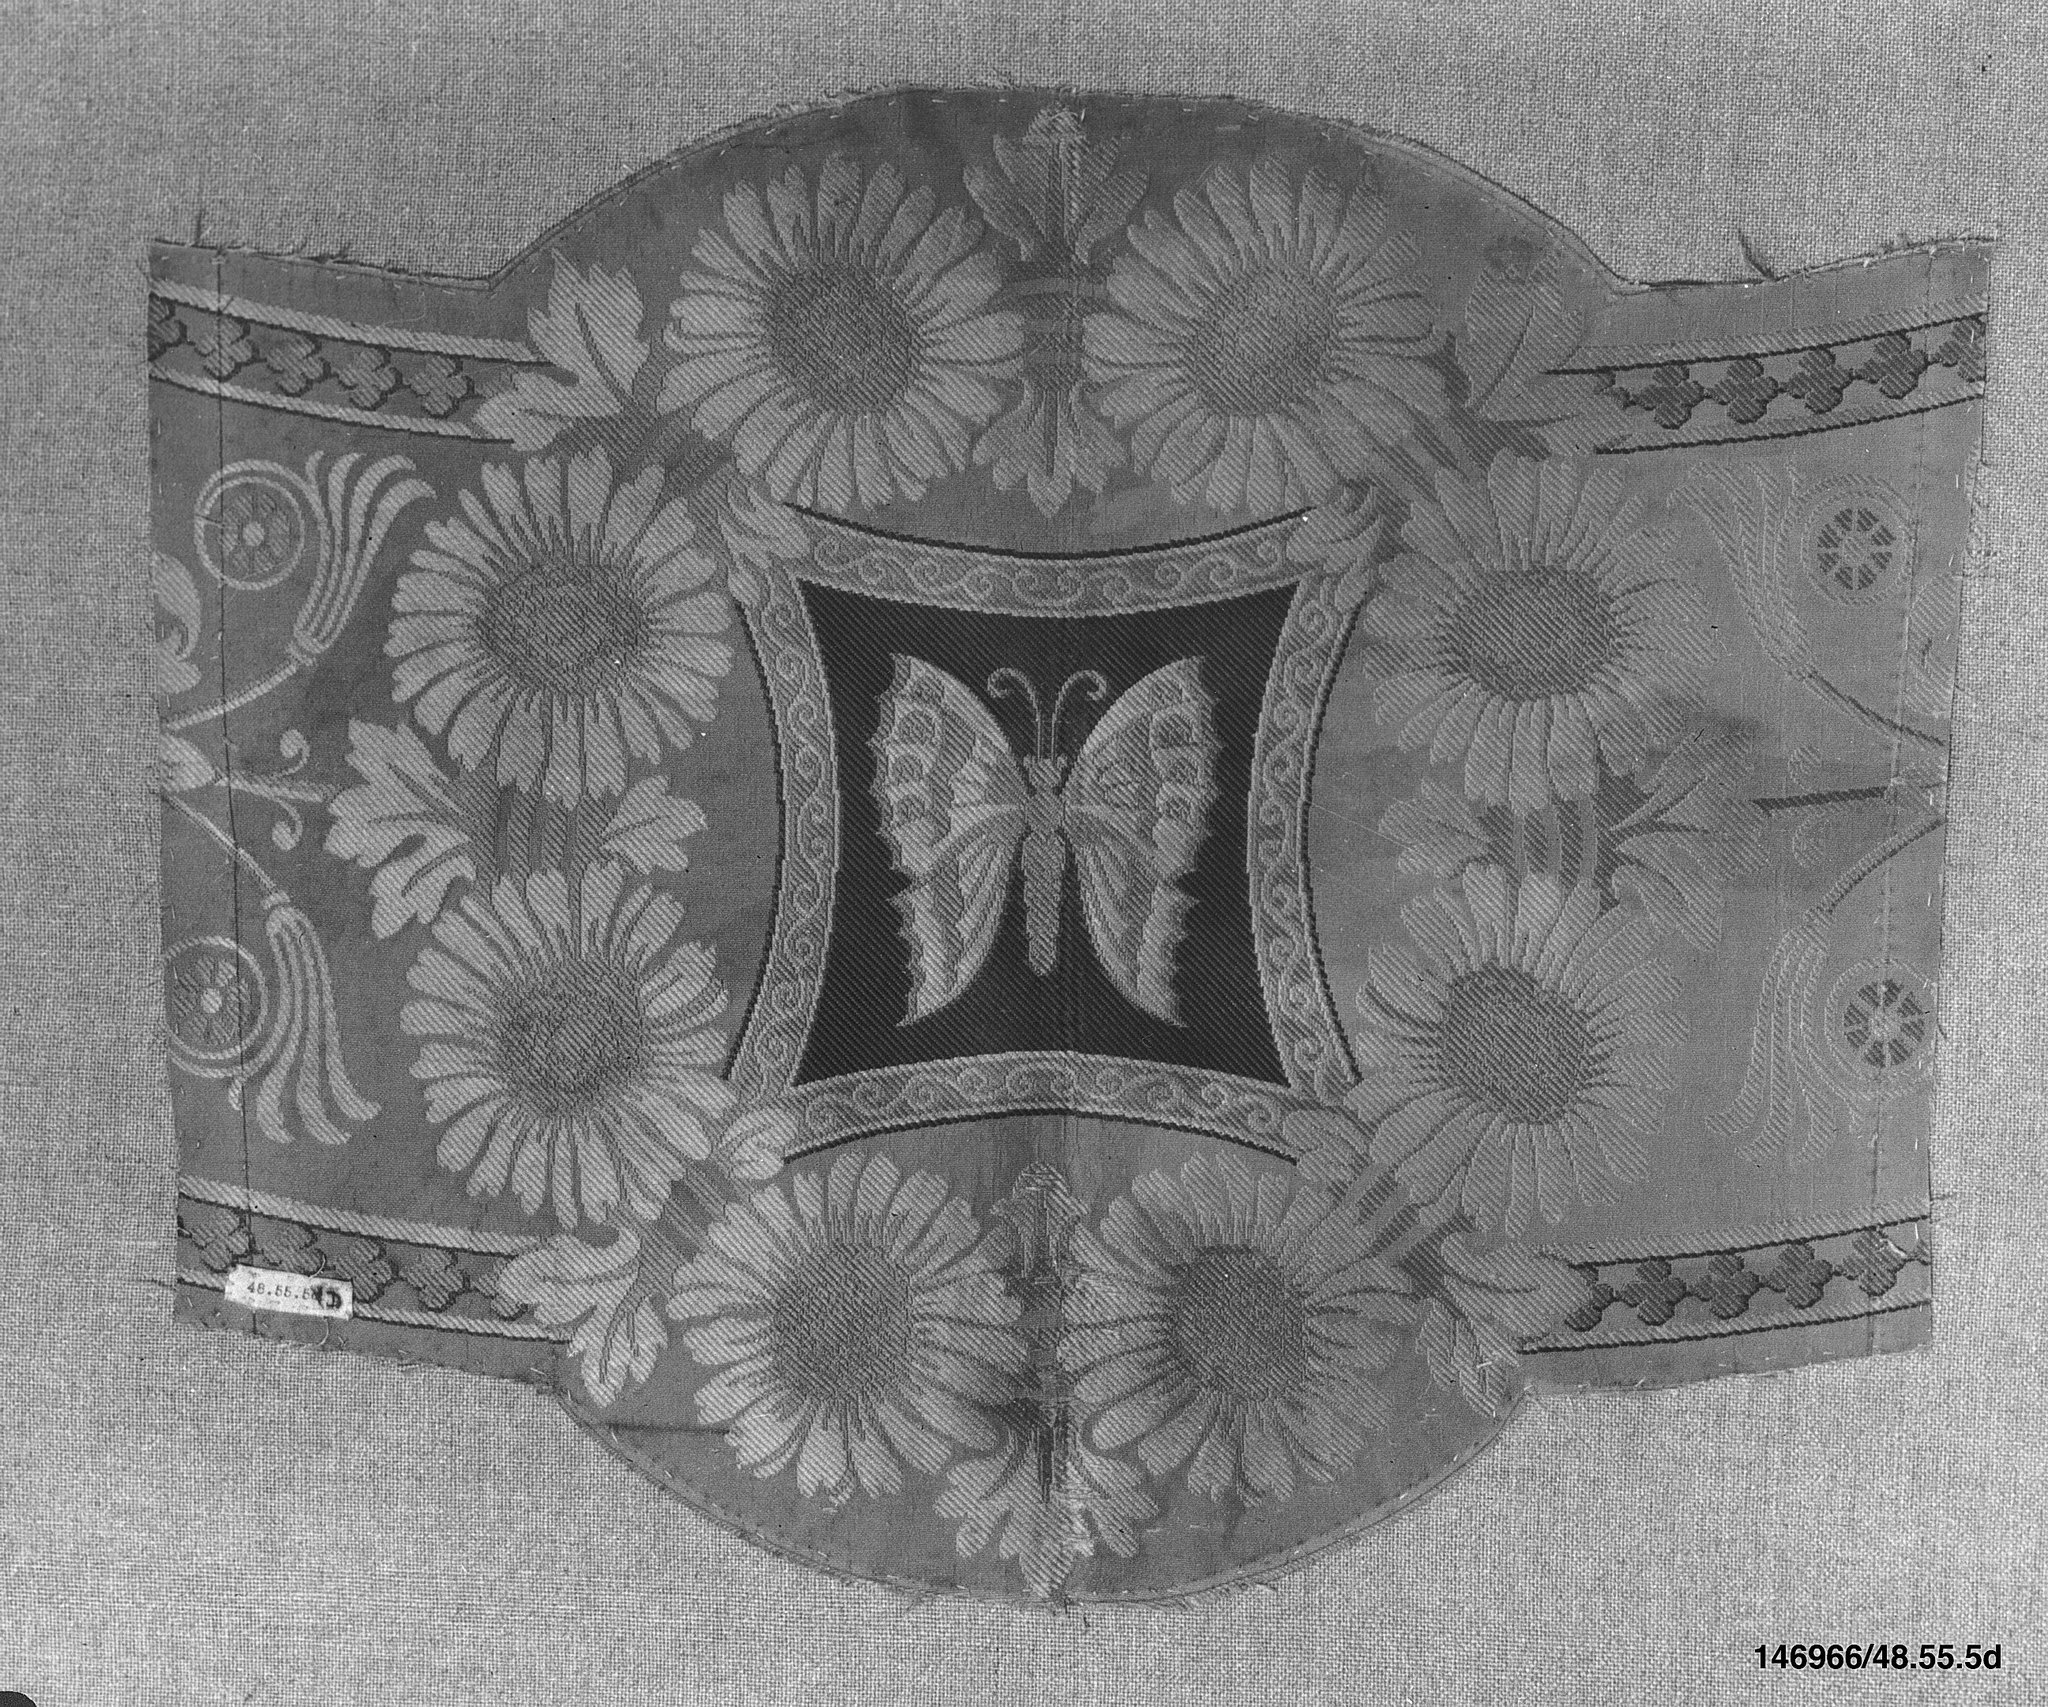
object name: piece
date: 1801-1833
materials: silk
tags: butterflies,flowers